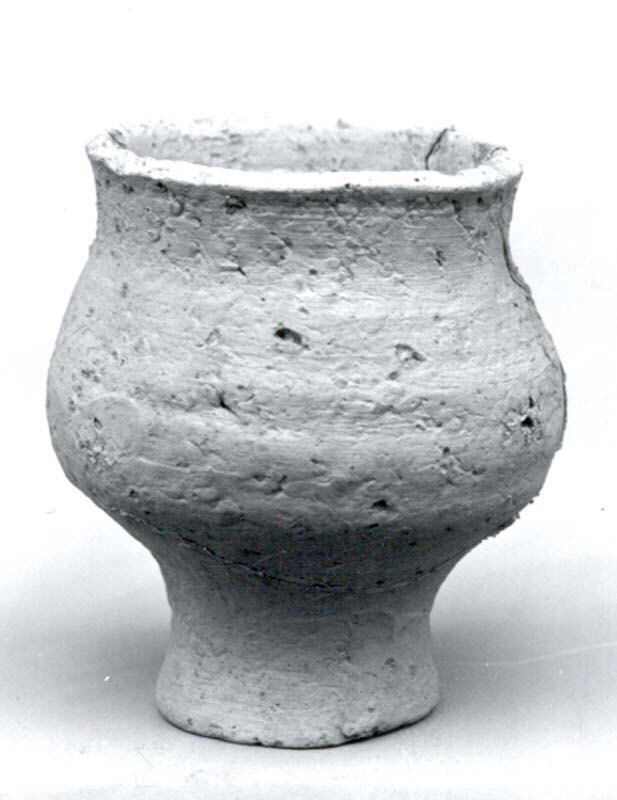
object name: bowl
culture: sasanian or islamic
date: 501-800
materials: ceramic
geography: iran